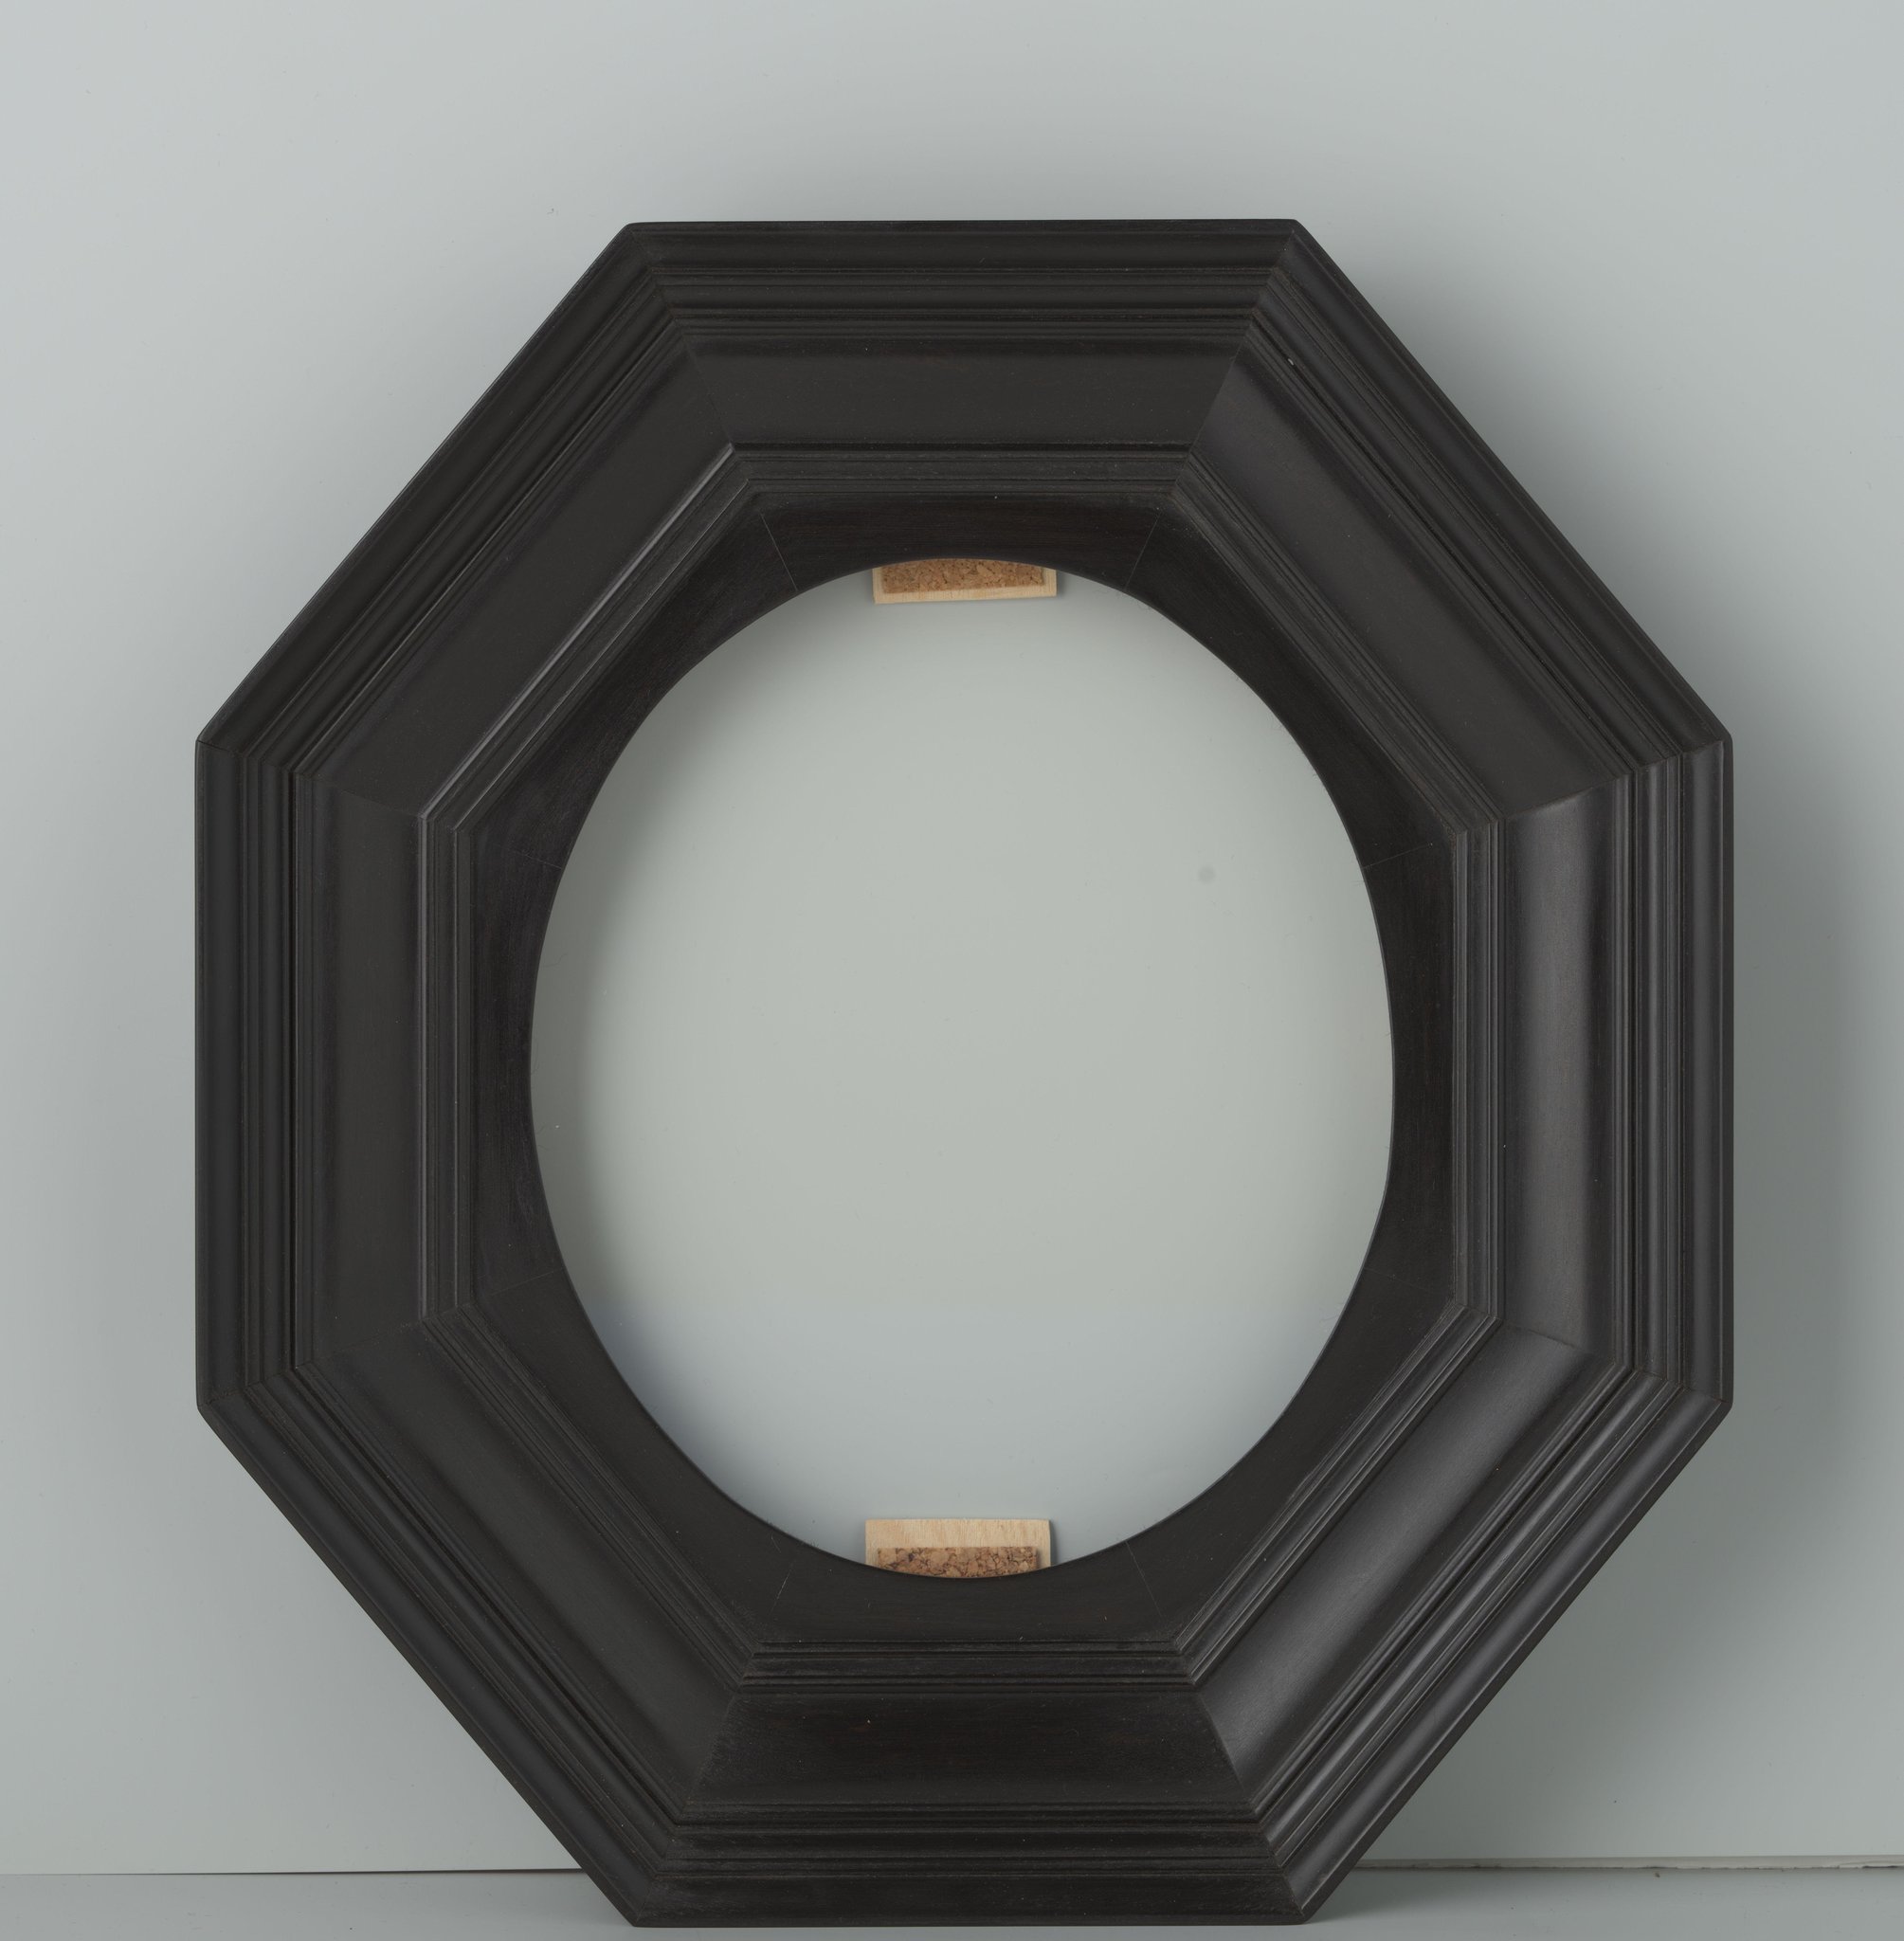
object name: frame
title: Zwarte achthoekige profiellijst met ovalen dagkant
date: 2023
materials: wood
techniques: veneering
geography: haarlem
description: Achthoekige profiellijst met gezwart ebbenhouten fineer en een ovalen dagkant. De grenen zool heeft een halfhoutverbinding. Reproductie van één van oorspronkelijke lijstjes om de zeven portretten van Cornelis Samuelsz/ van Esch en zijn familie (SK-A-1747-A t/m G).